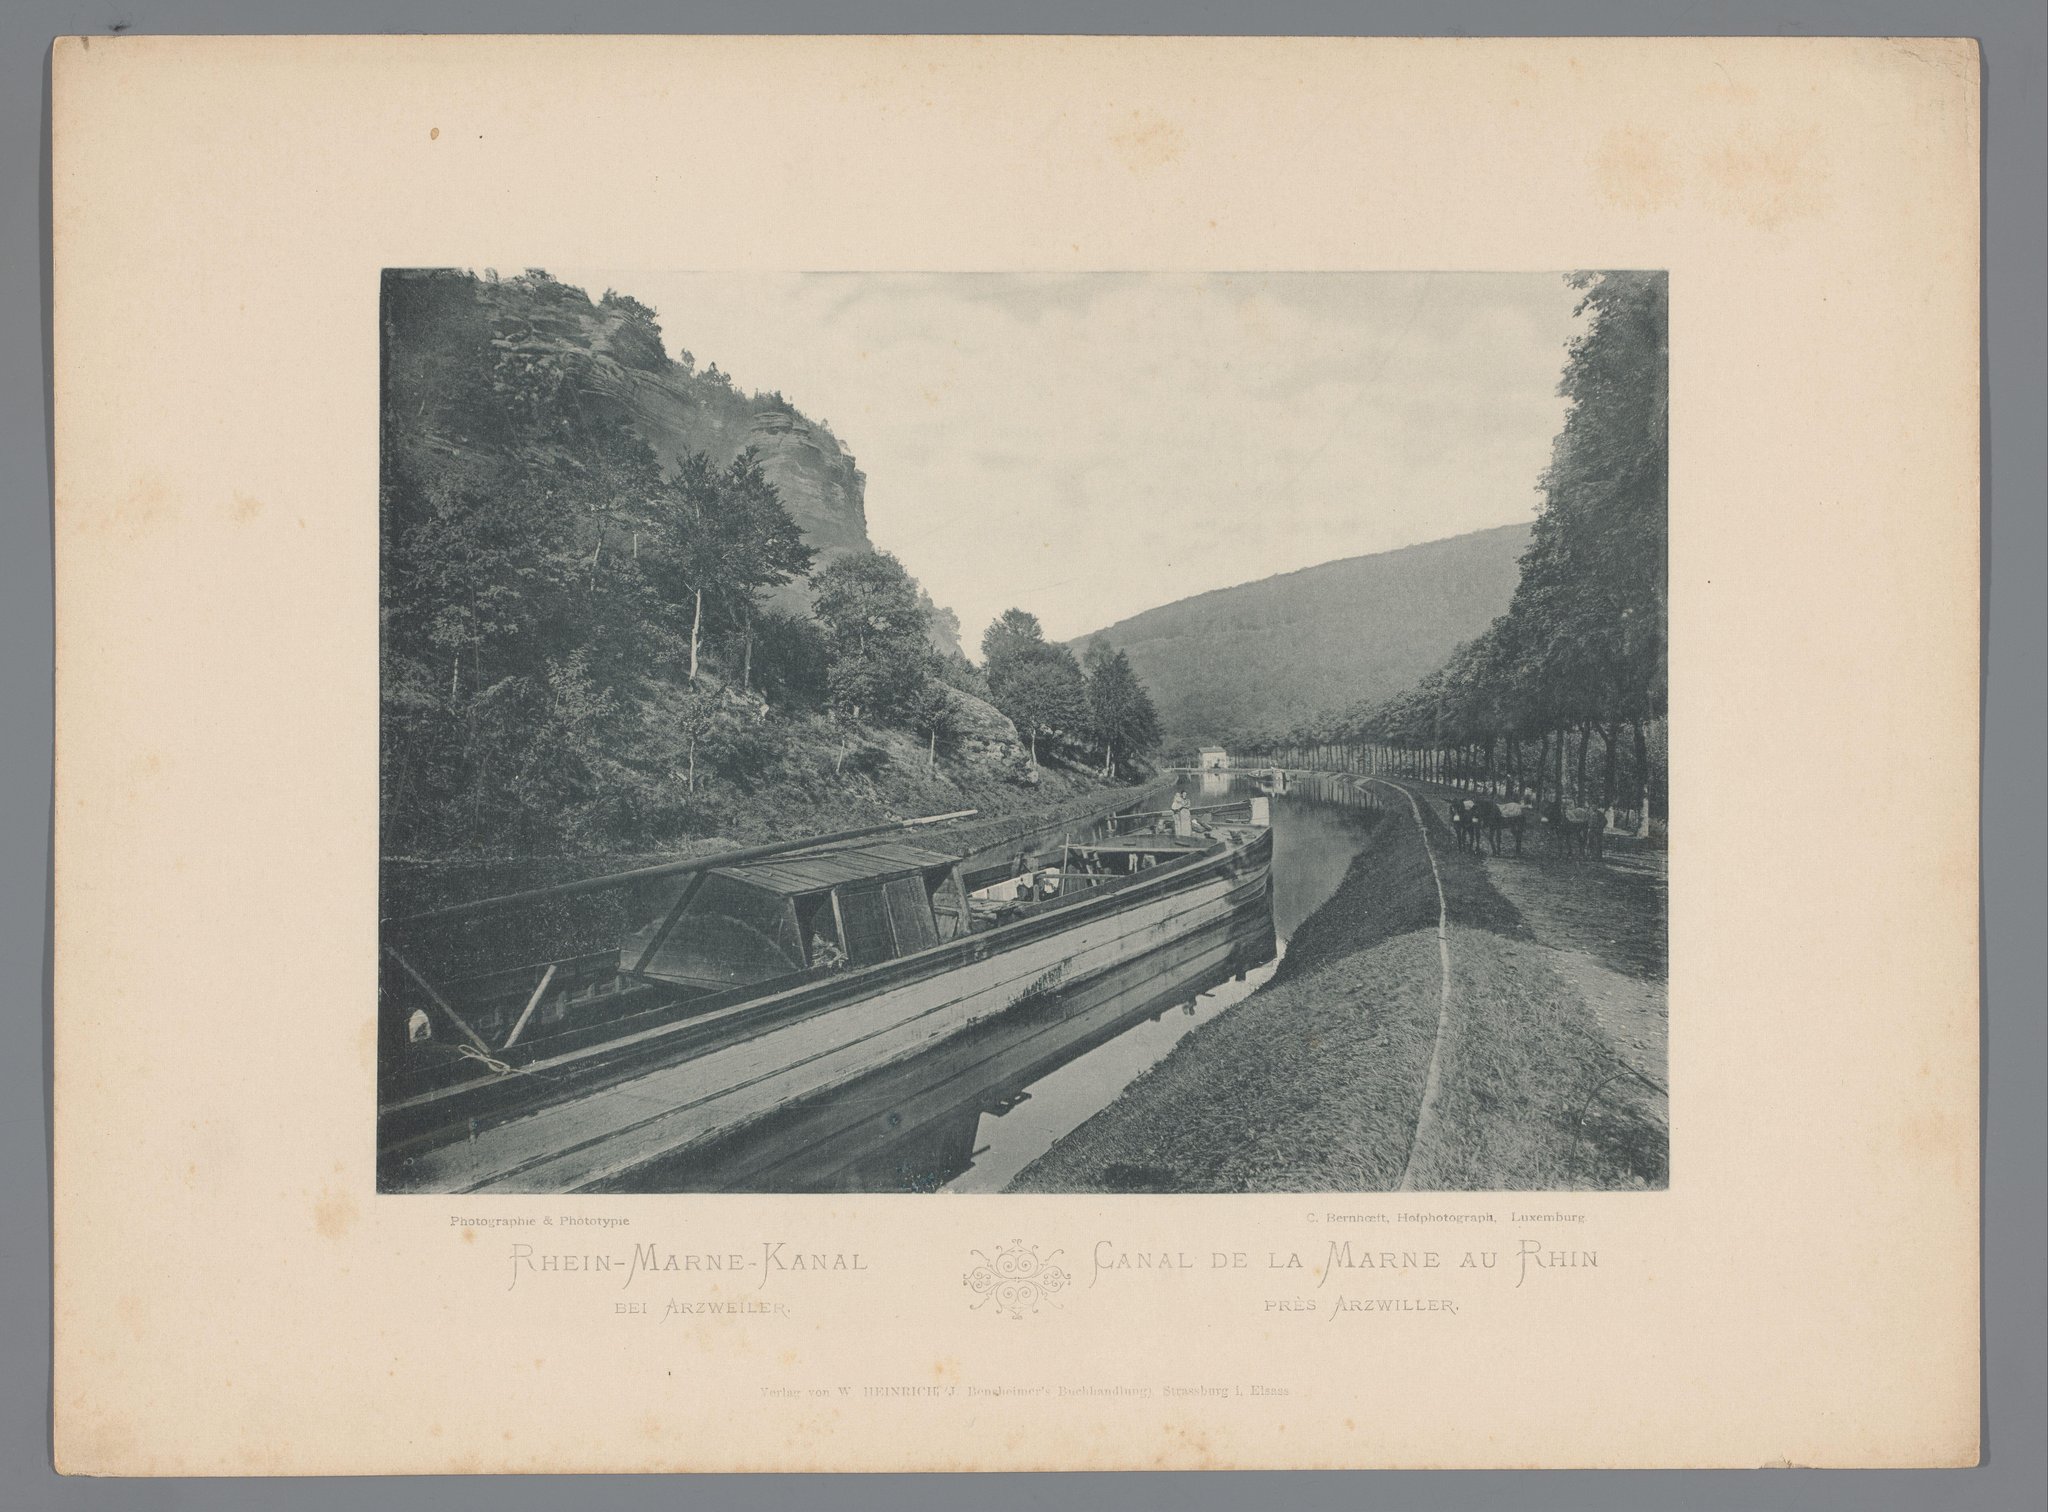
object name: photomechanical print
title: Gezicht op het Marne-Rijnkanaal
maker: charles bernhoeft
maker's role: publisher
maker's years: 1859-1933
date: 1889-1894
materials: paper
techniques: photograph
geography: straatsburg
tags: canal, landscapes with waters, waterscapes, seascapes (in the temperate zone) (+ landscape with figures, staffage)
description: Deze prent maakt deel uit van een omslag met 100 prenten.